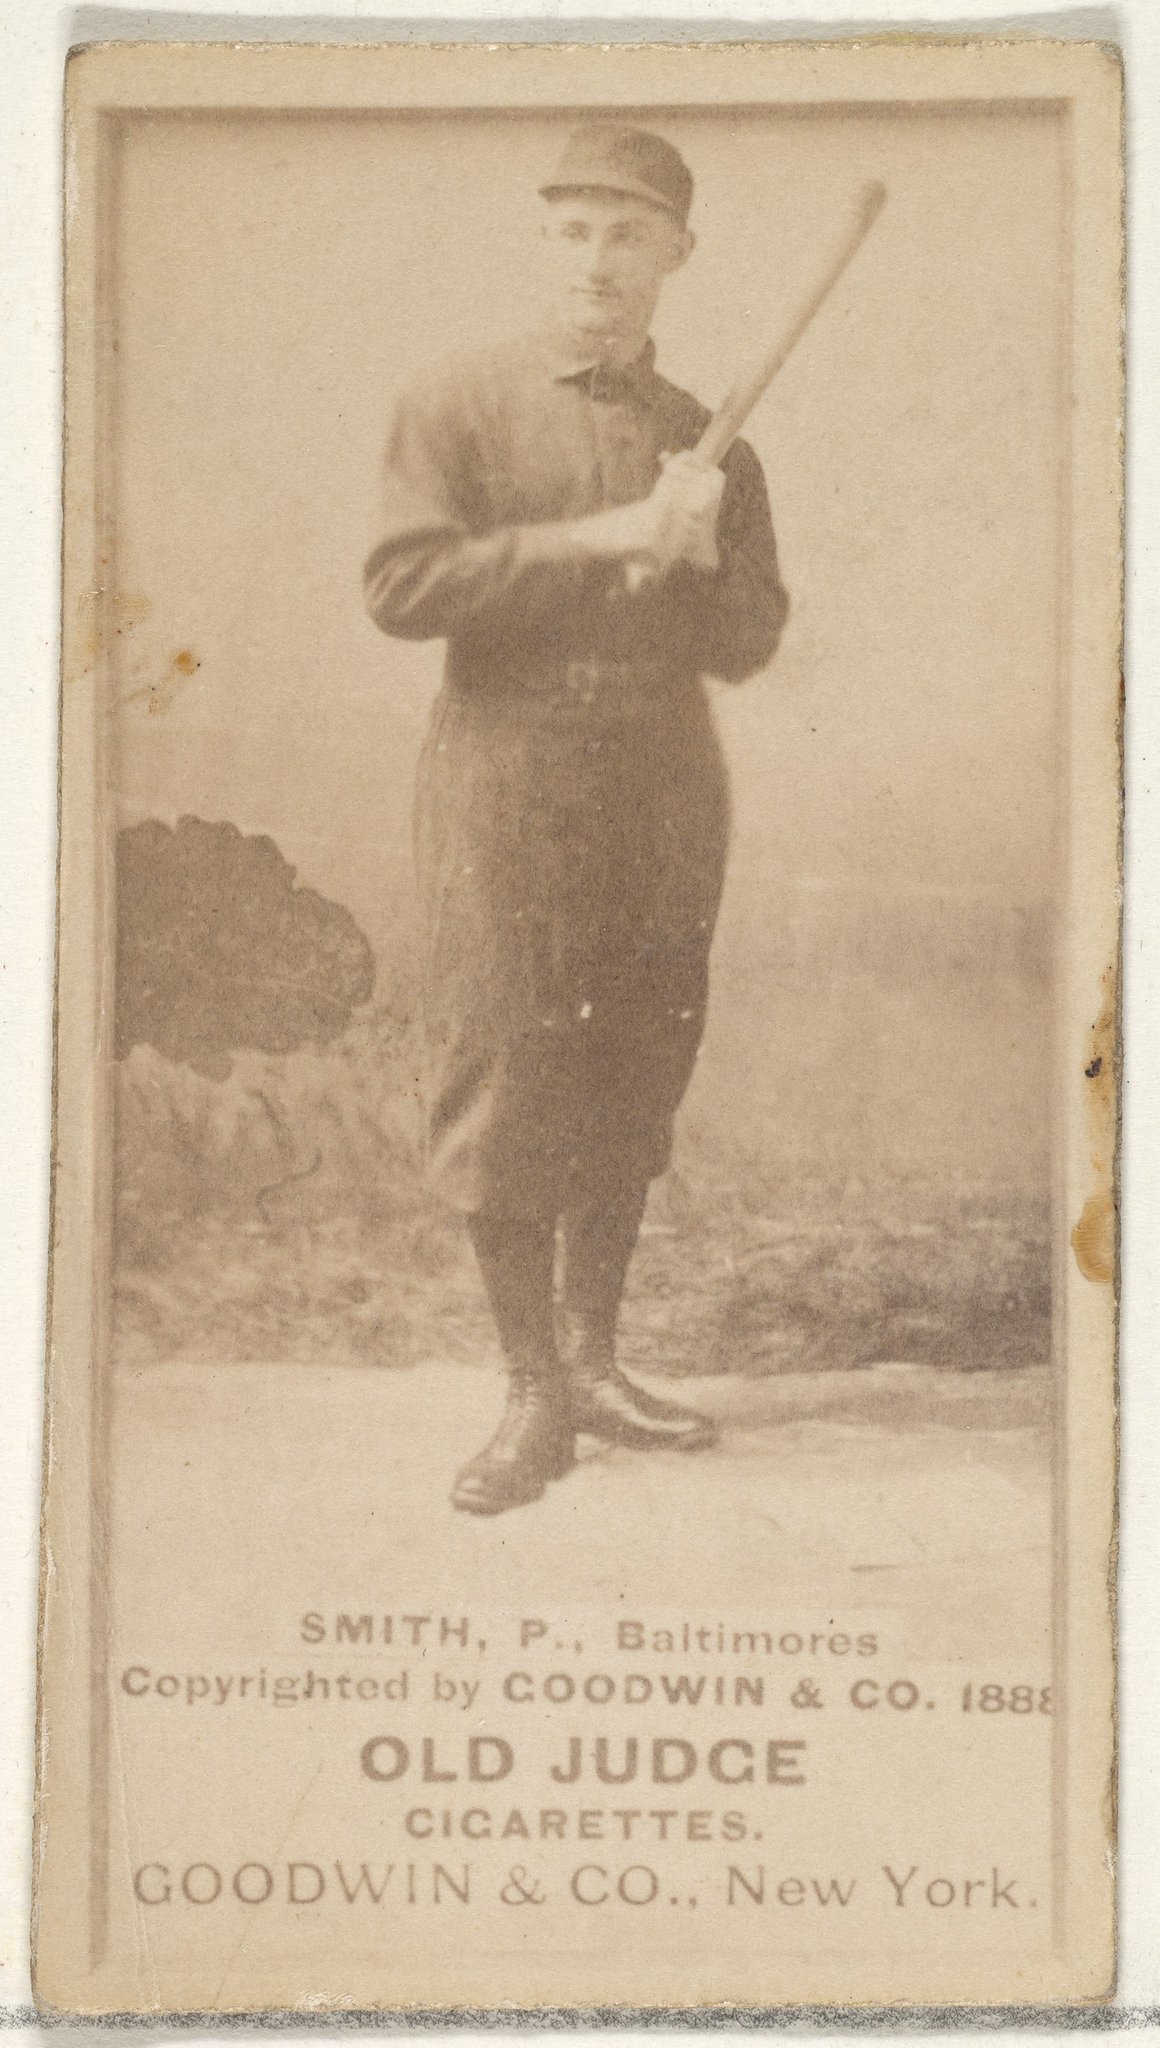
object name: baseball card, photograph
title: Smith, Pitcher, Baltimore Orioles, from the Old Judge series (N172) for Old Judge Cigarettes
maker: goodwin & company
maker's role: publisher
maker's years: 1850-1950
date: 1888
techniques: albumen silver print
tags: men,portraits,baseball,athletes